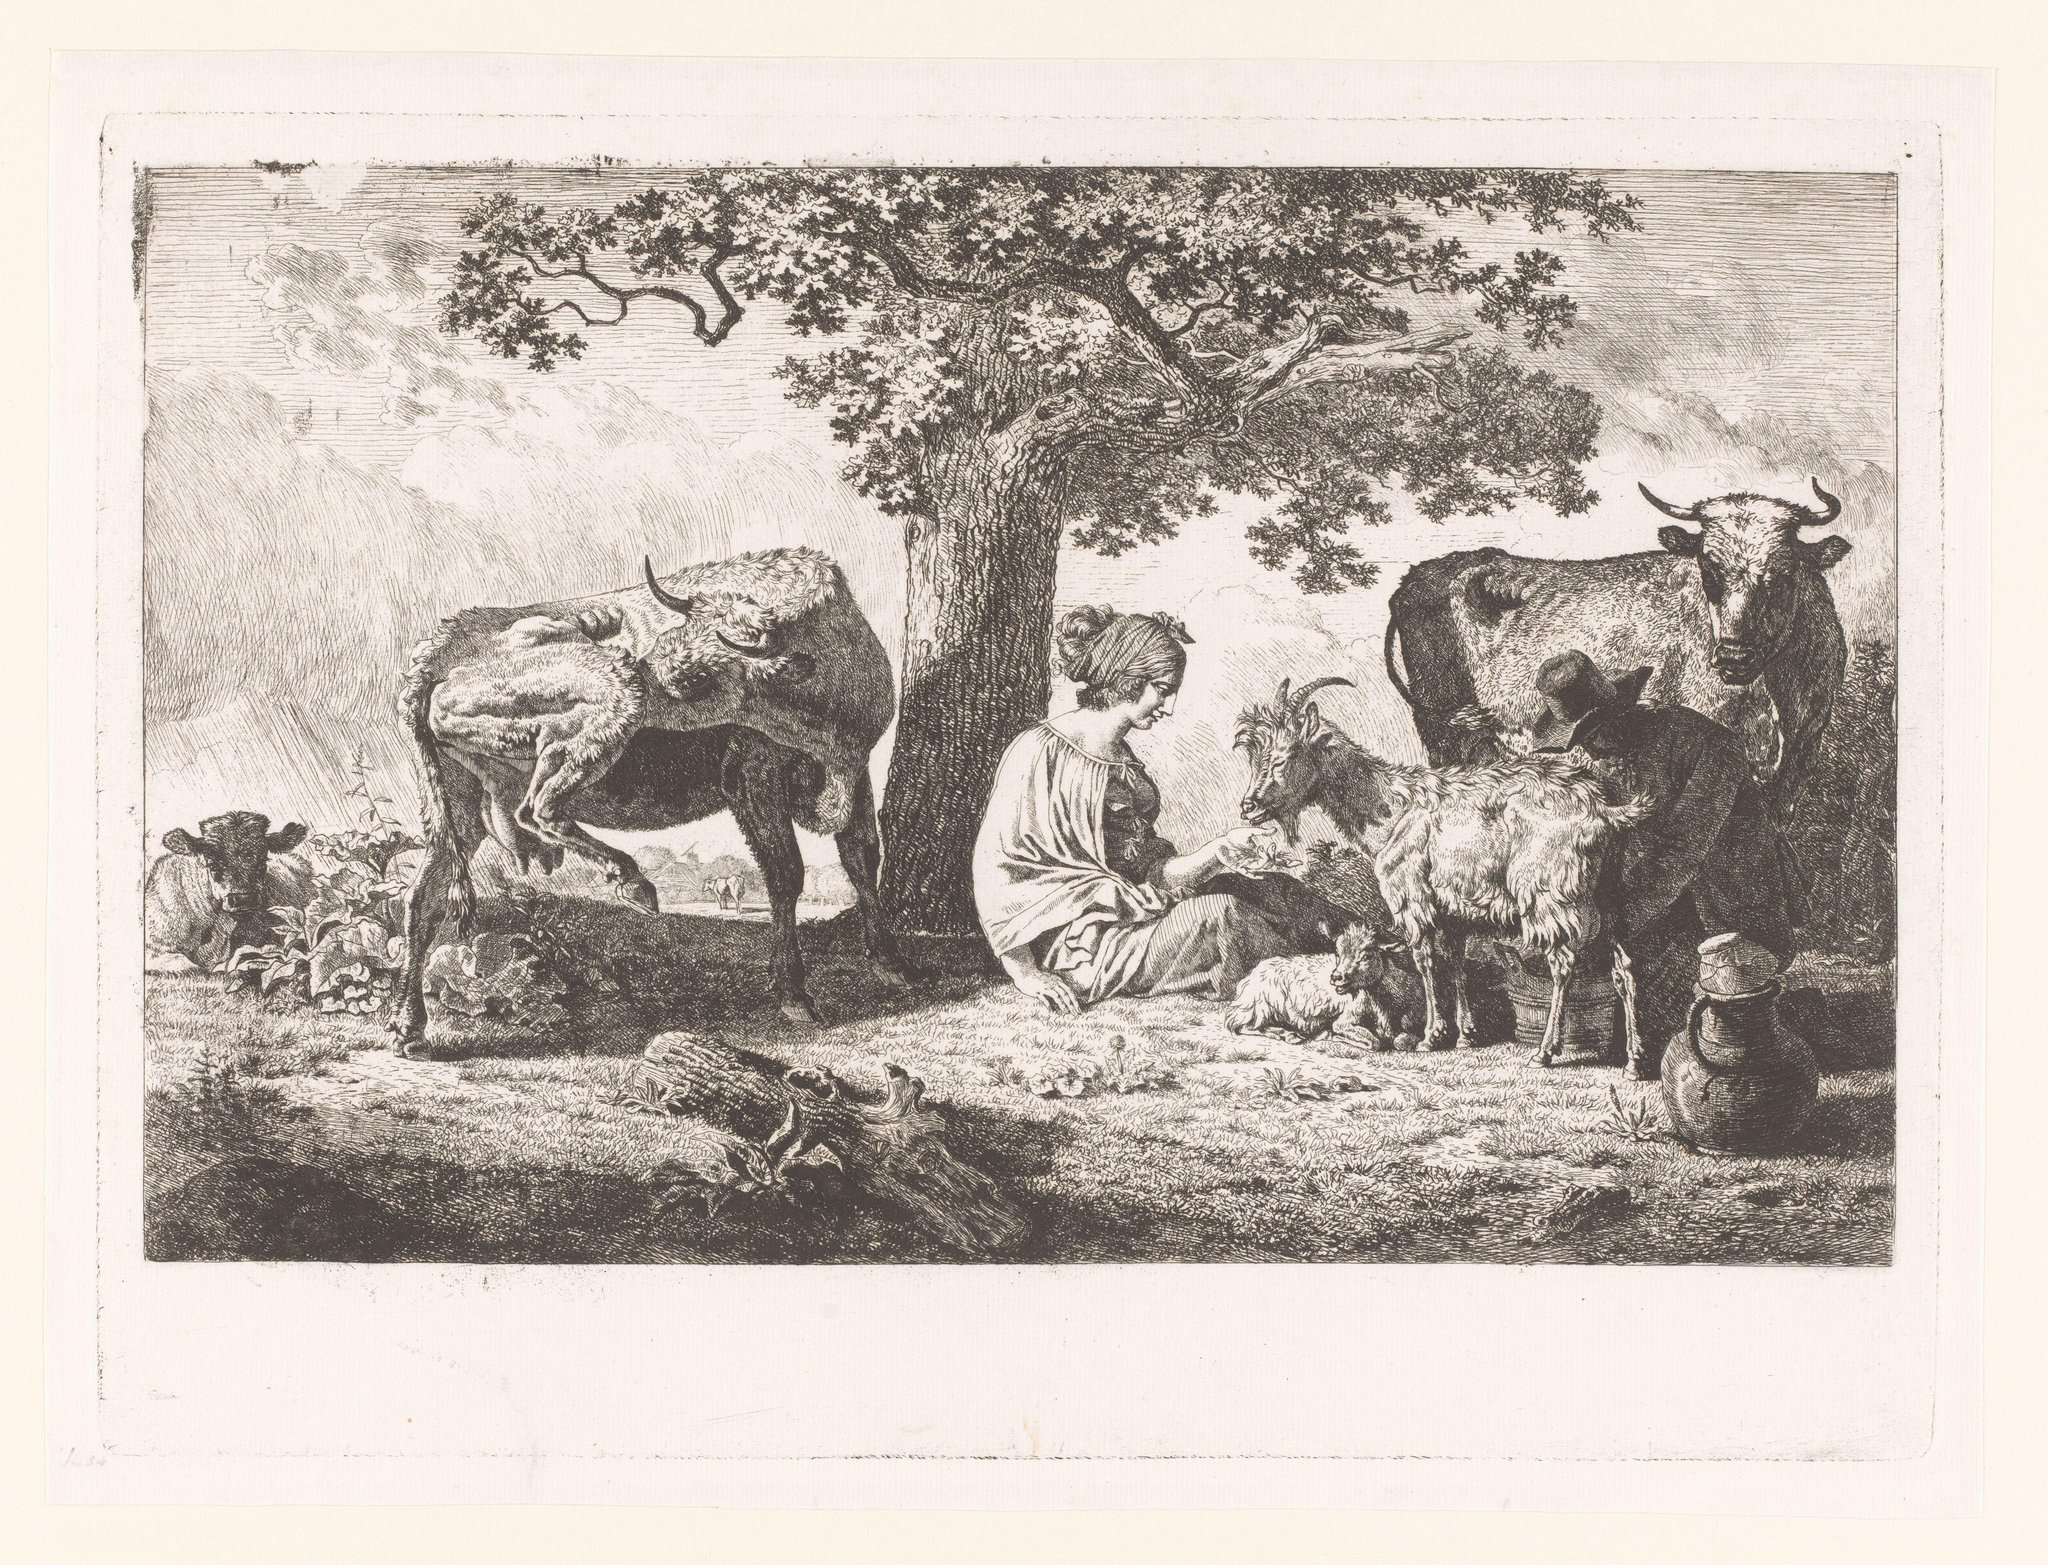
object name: print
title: Man melkt een geit terwijl een vrouw de geit voert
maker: jean louis demarne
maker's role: draughtsman, painter, print maker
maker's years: 1752-1829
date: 1762-1829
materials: paper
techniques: etching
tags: herding, herdsman, herdswoman, shepherd, shepherdess, cowherd, etc., cattle, goat, milking